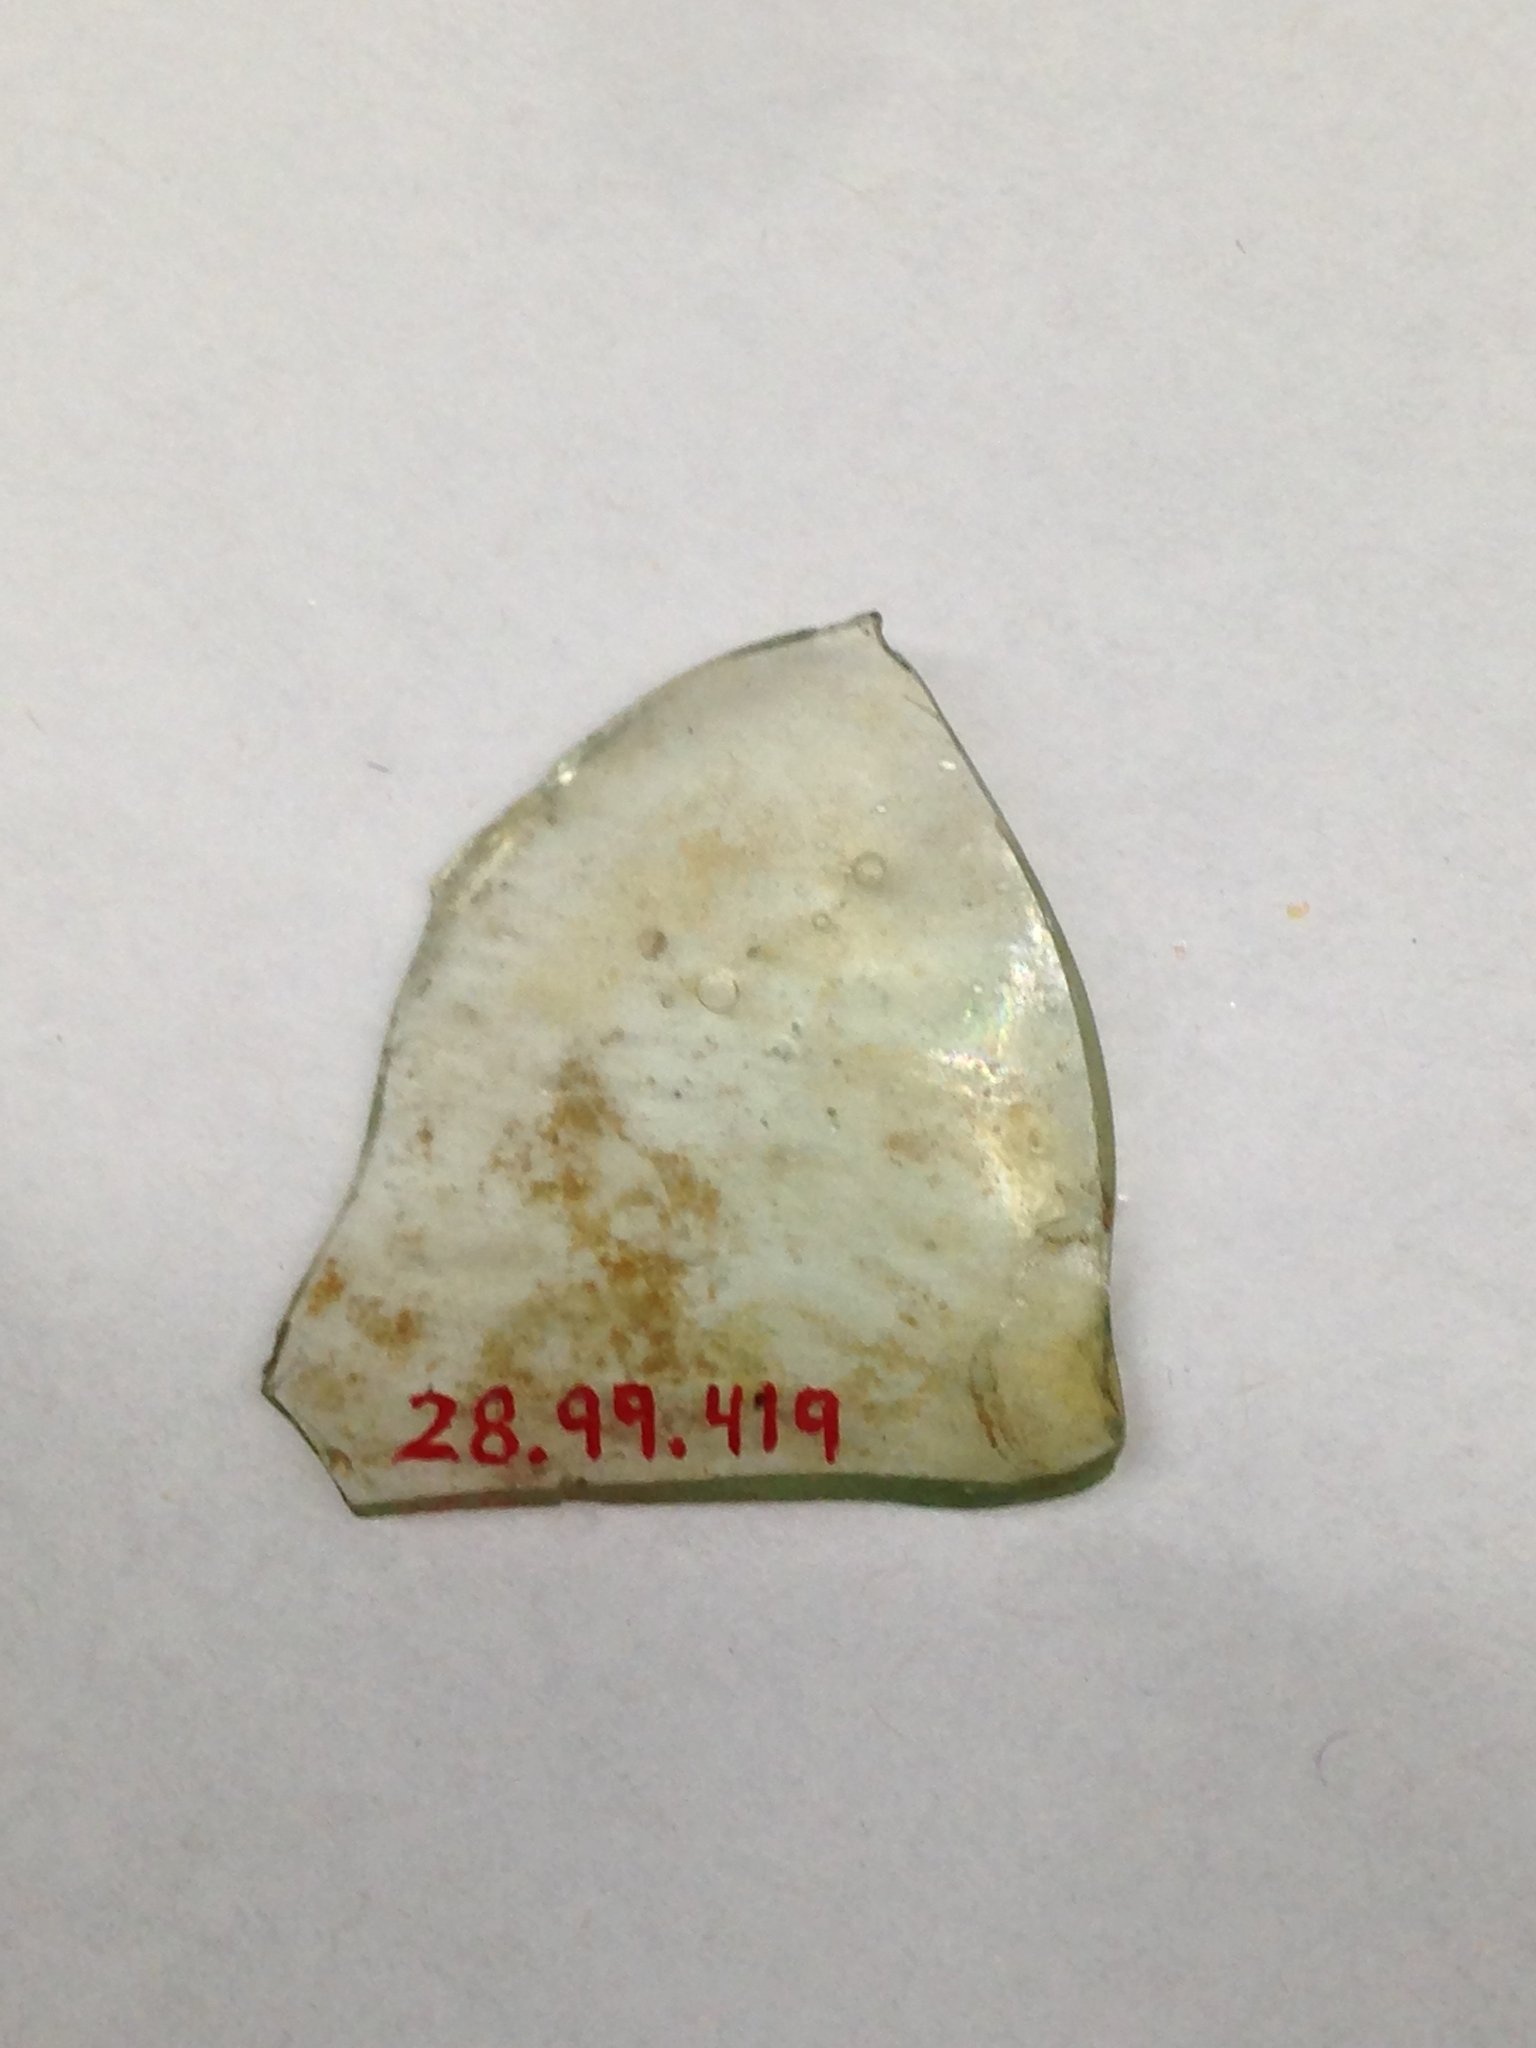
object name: fragment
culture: european or middle eastern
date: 1150-1250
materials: ceramic, glass